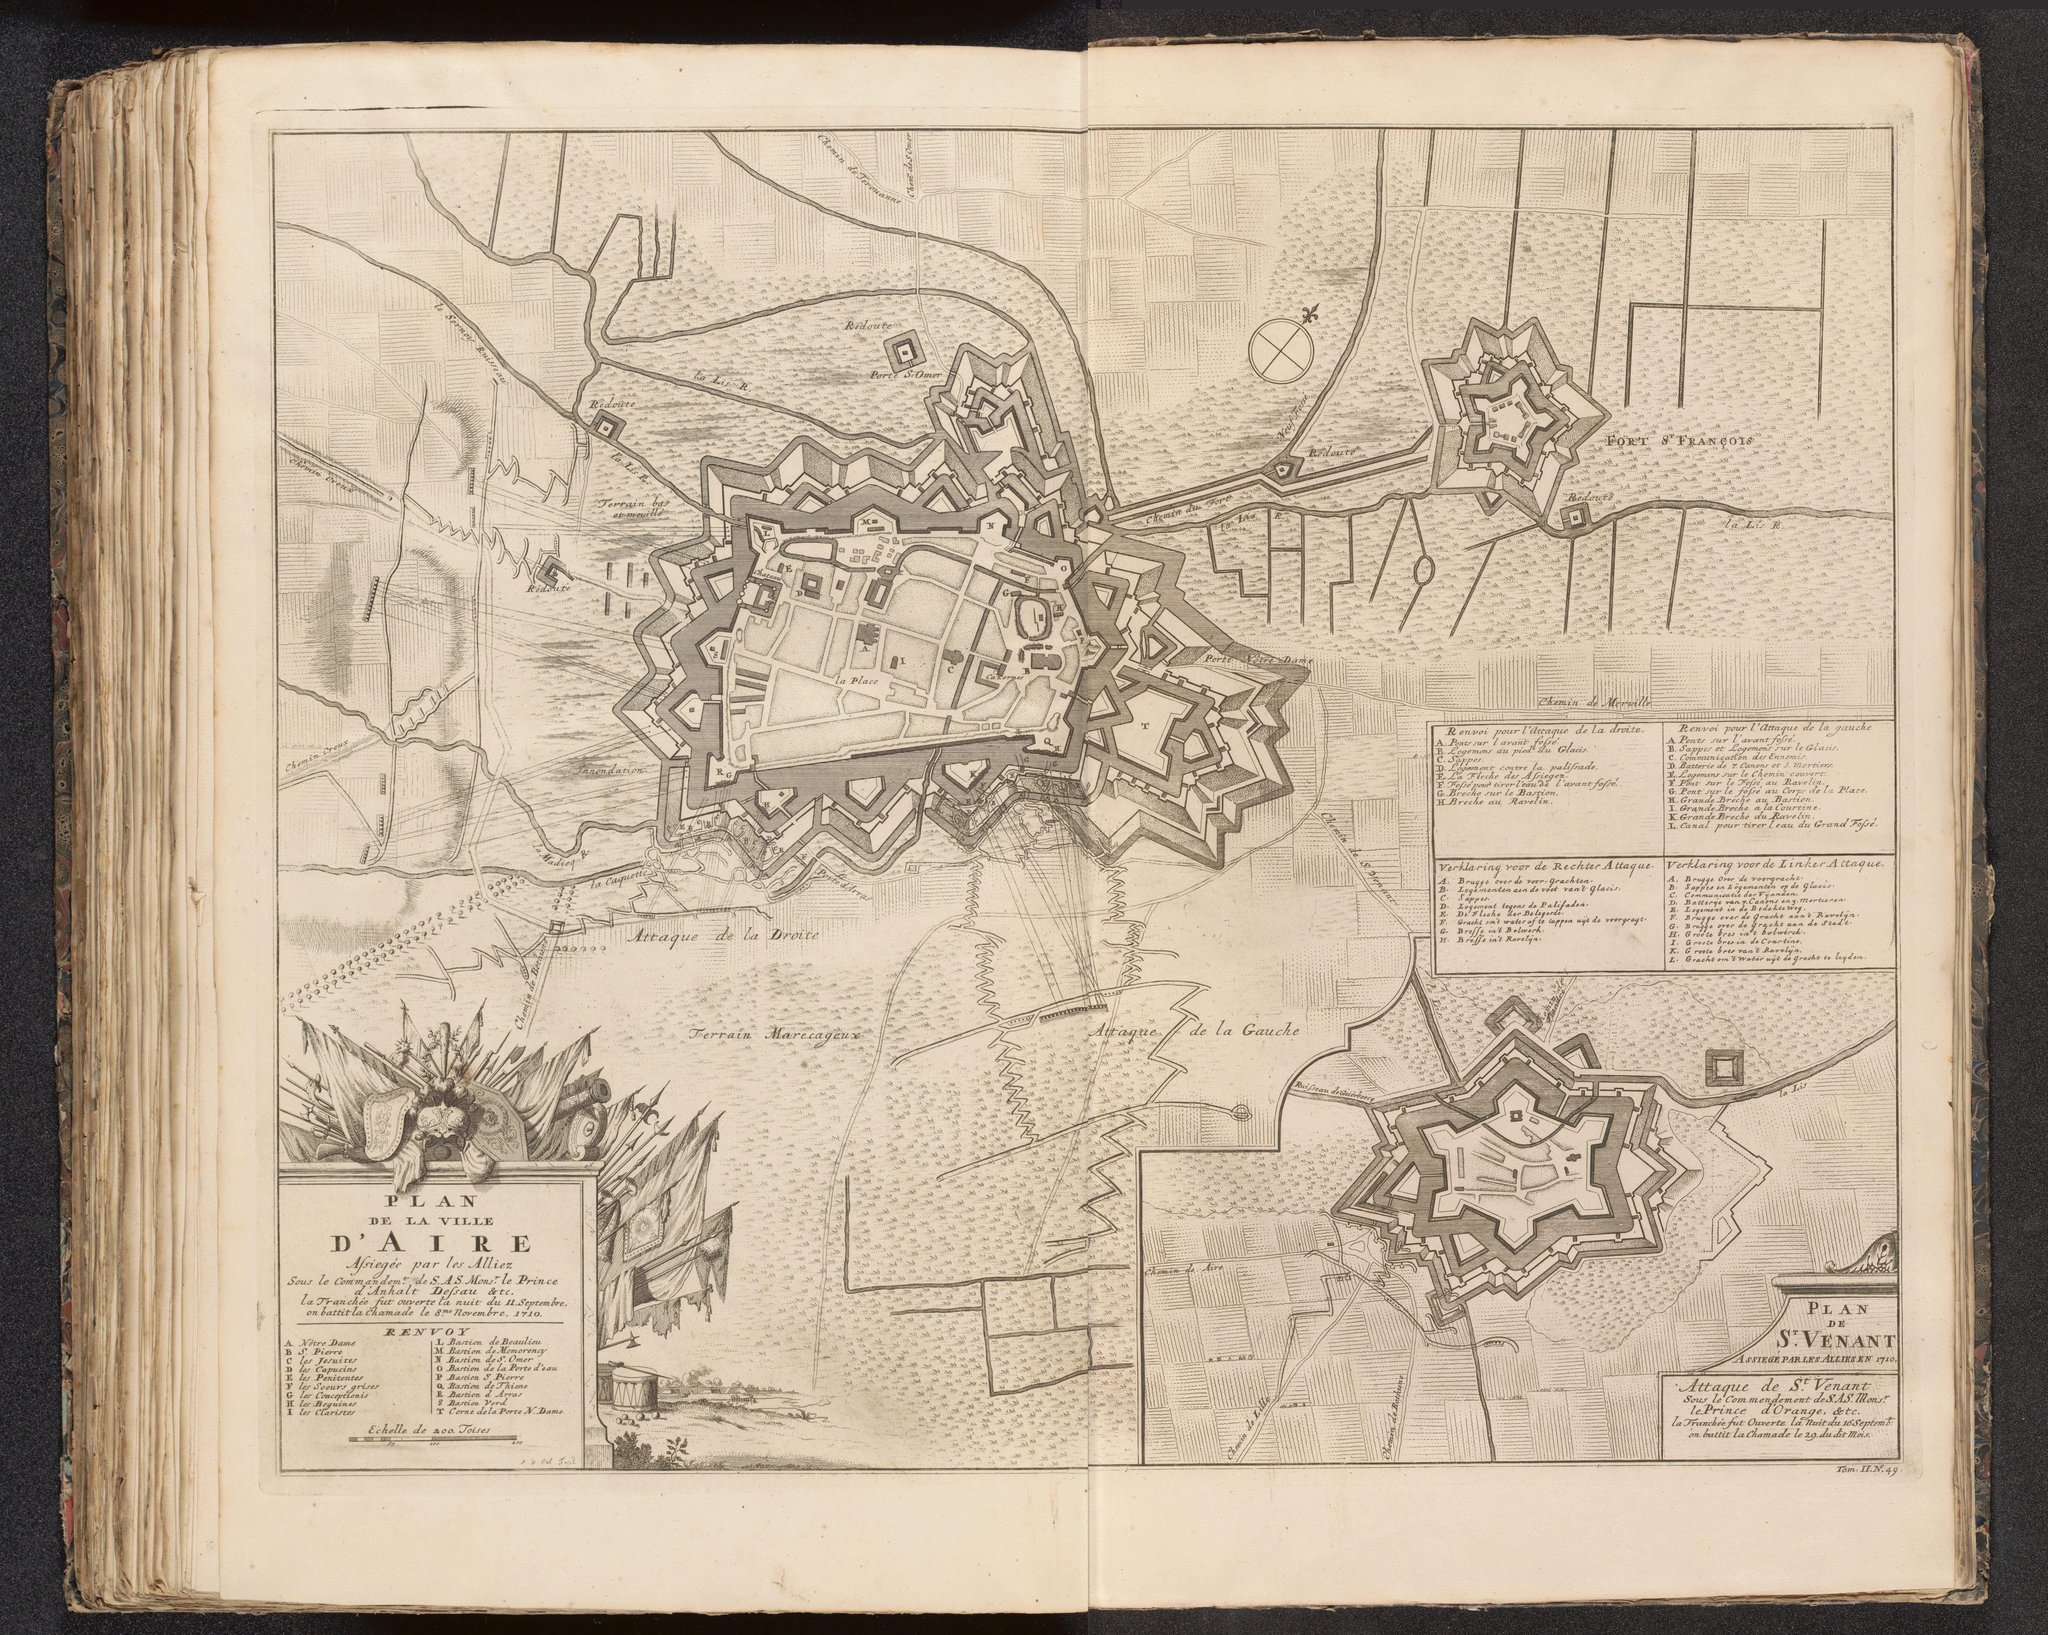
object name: map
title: Kaart van het beleg van Aire, 1710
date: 1710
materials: paper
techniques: etching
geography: the hague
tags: johan willem friso (prins van oranje-nassau), john churchill (1e hertog van marlborough), siege, position war, maps of cities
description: Kaart van het beleg van Aire door de Geallieerden onder prins Leopold I van Anhalt-Dessau, belegerd vanaf 11 september en ingenomen op 8 november 1710. Rechtsonder een inzet met het beleg van Saint-Venant in 1710. Genummerd rechtsonder: Tom. II. No. 49. Illustratie in het tweede deel van : [Jean] du Mont, Oorlogskundige beschryving van de veldslagen en belegeringen, der drie ... wydvermaarde krygsoversten... den Prins Eugenius van Savoye, den ... Hertog van Marlborough, en den Prins van Oranje en Nassau-Vriesland, in de editie van 1729. Dit tweede deel is hoofdzakelijk gewijd aan de daden van de hertog van Marlborough en prins Johan Willem Friso.